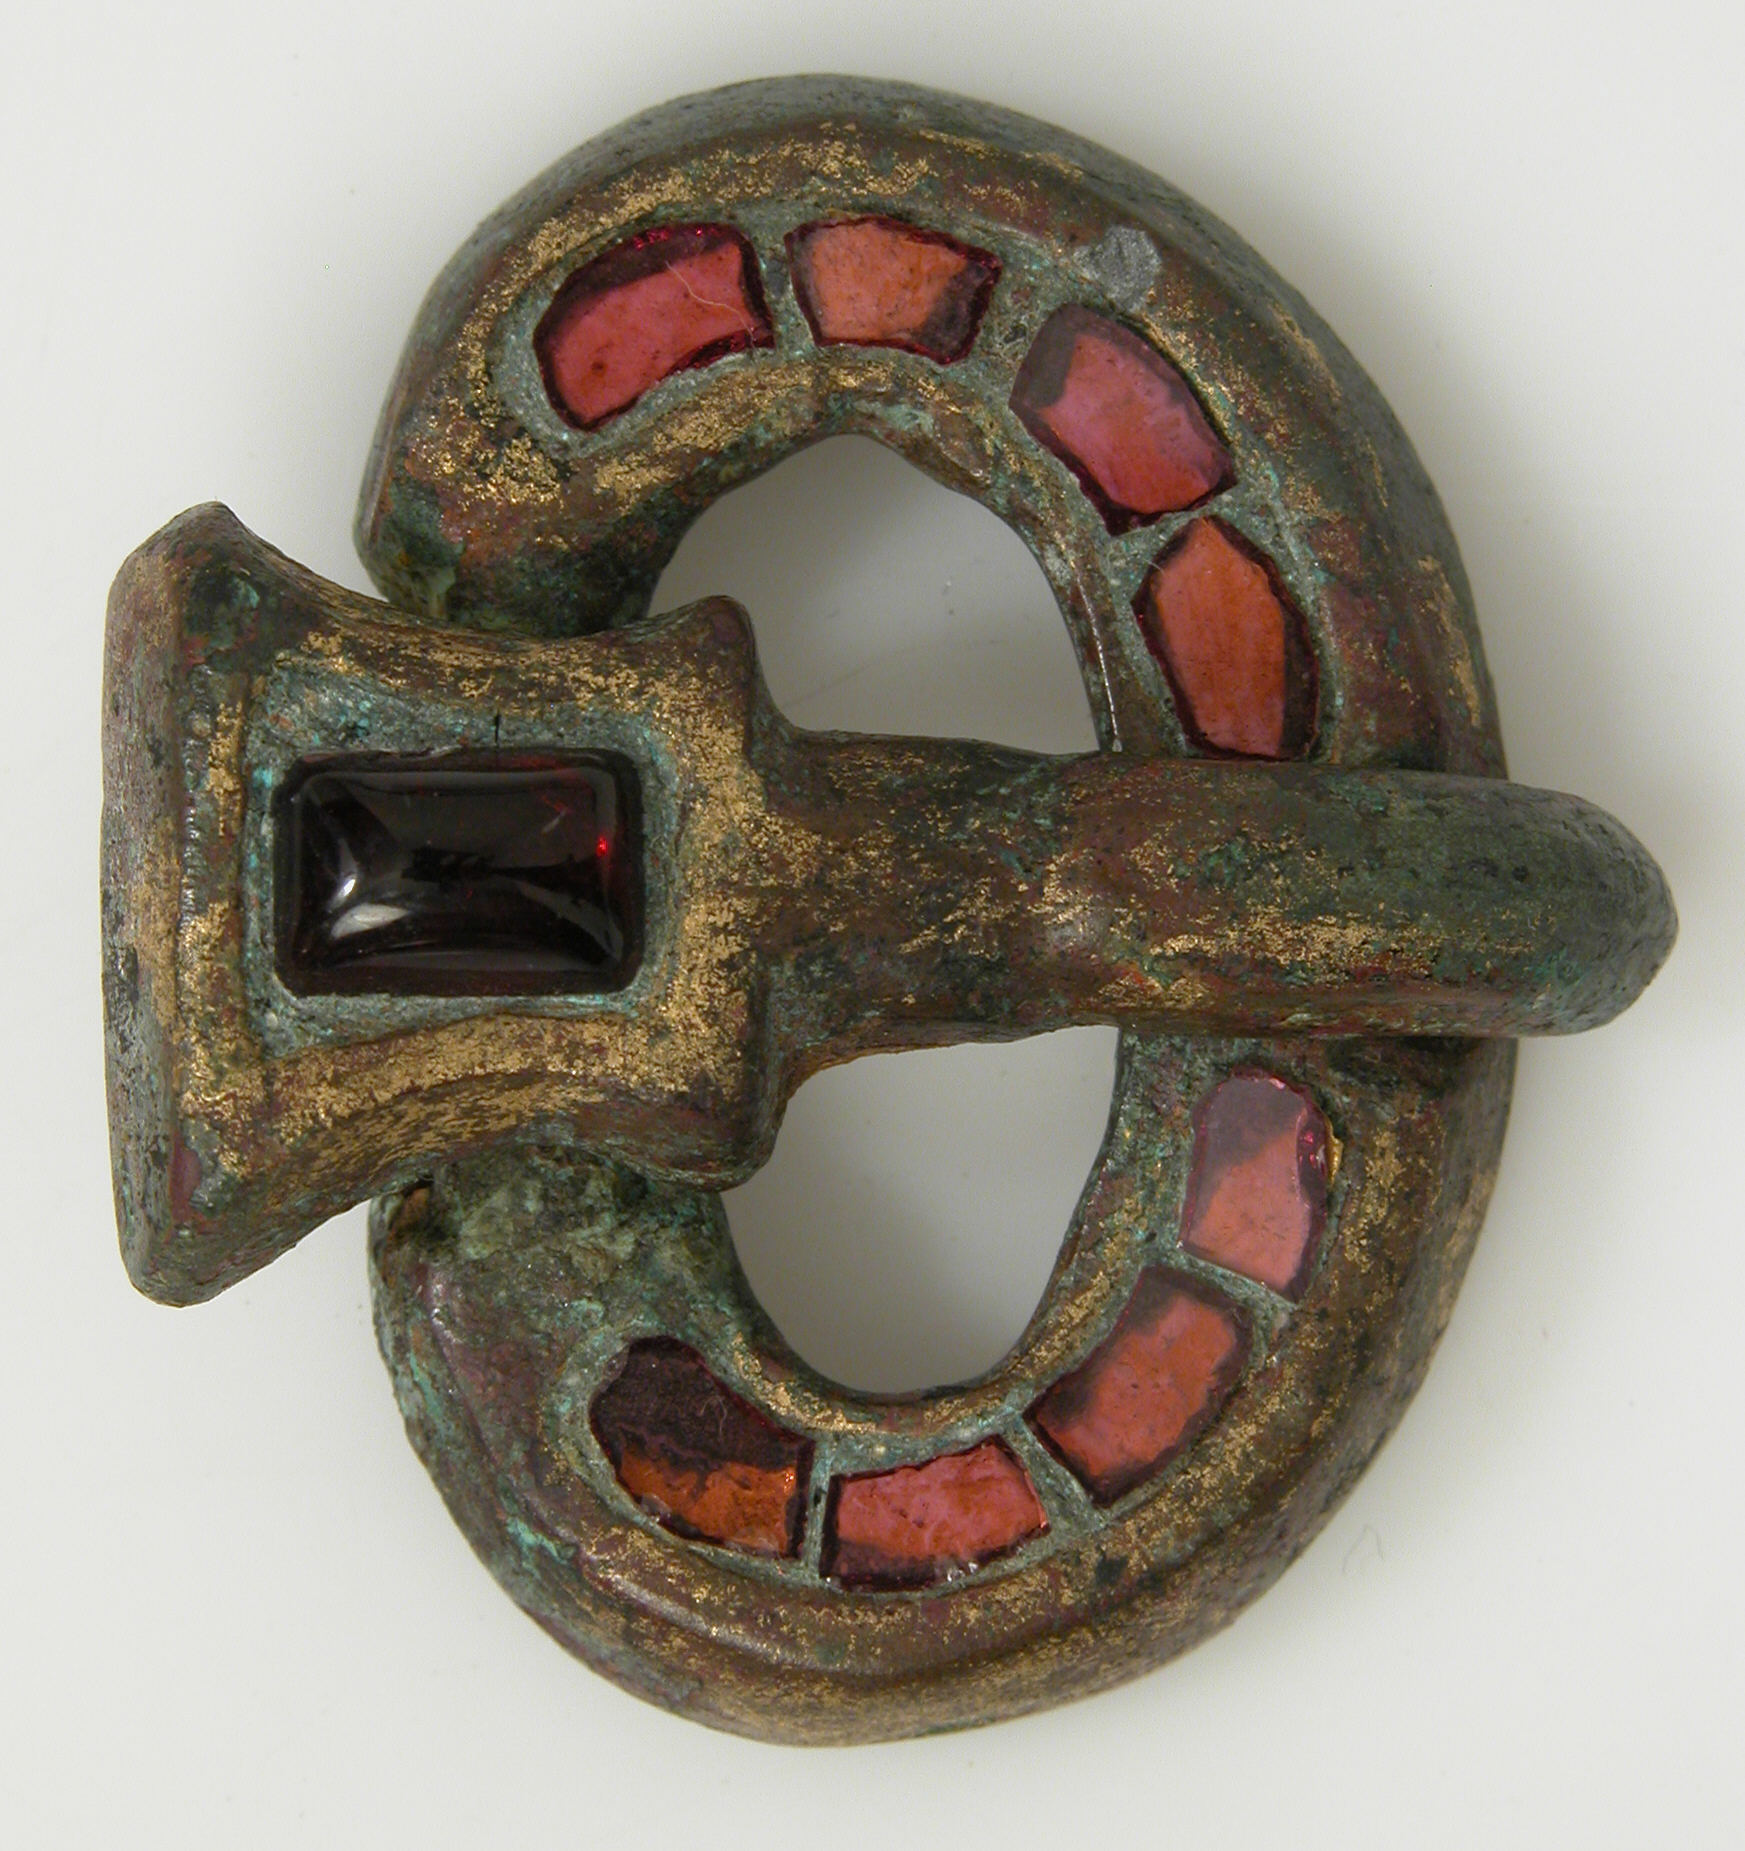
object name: buckle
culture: frankish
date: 500-550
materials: bronze, gemstone, gilt, glass, paste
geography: northern france